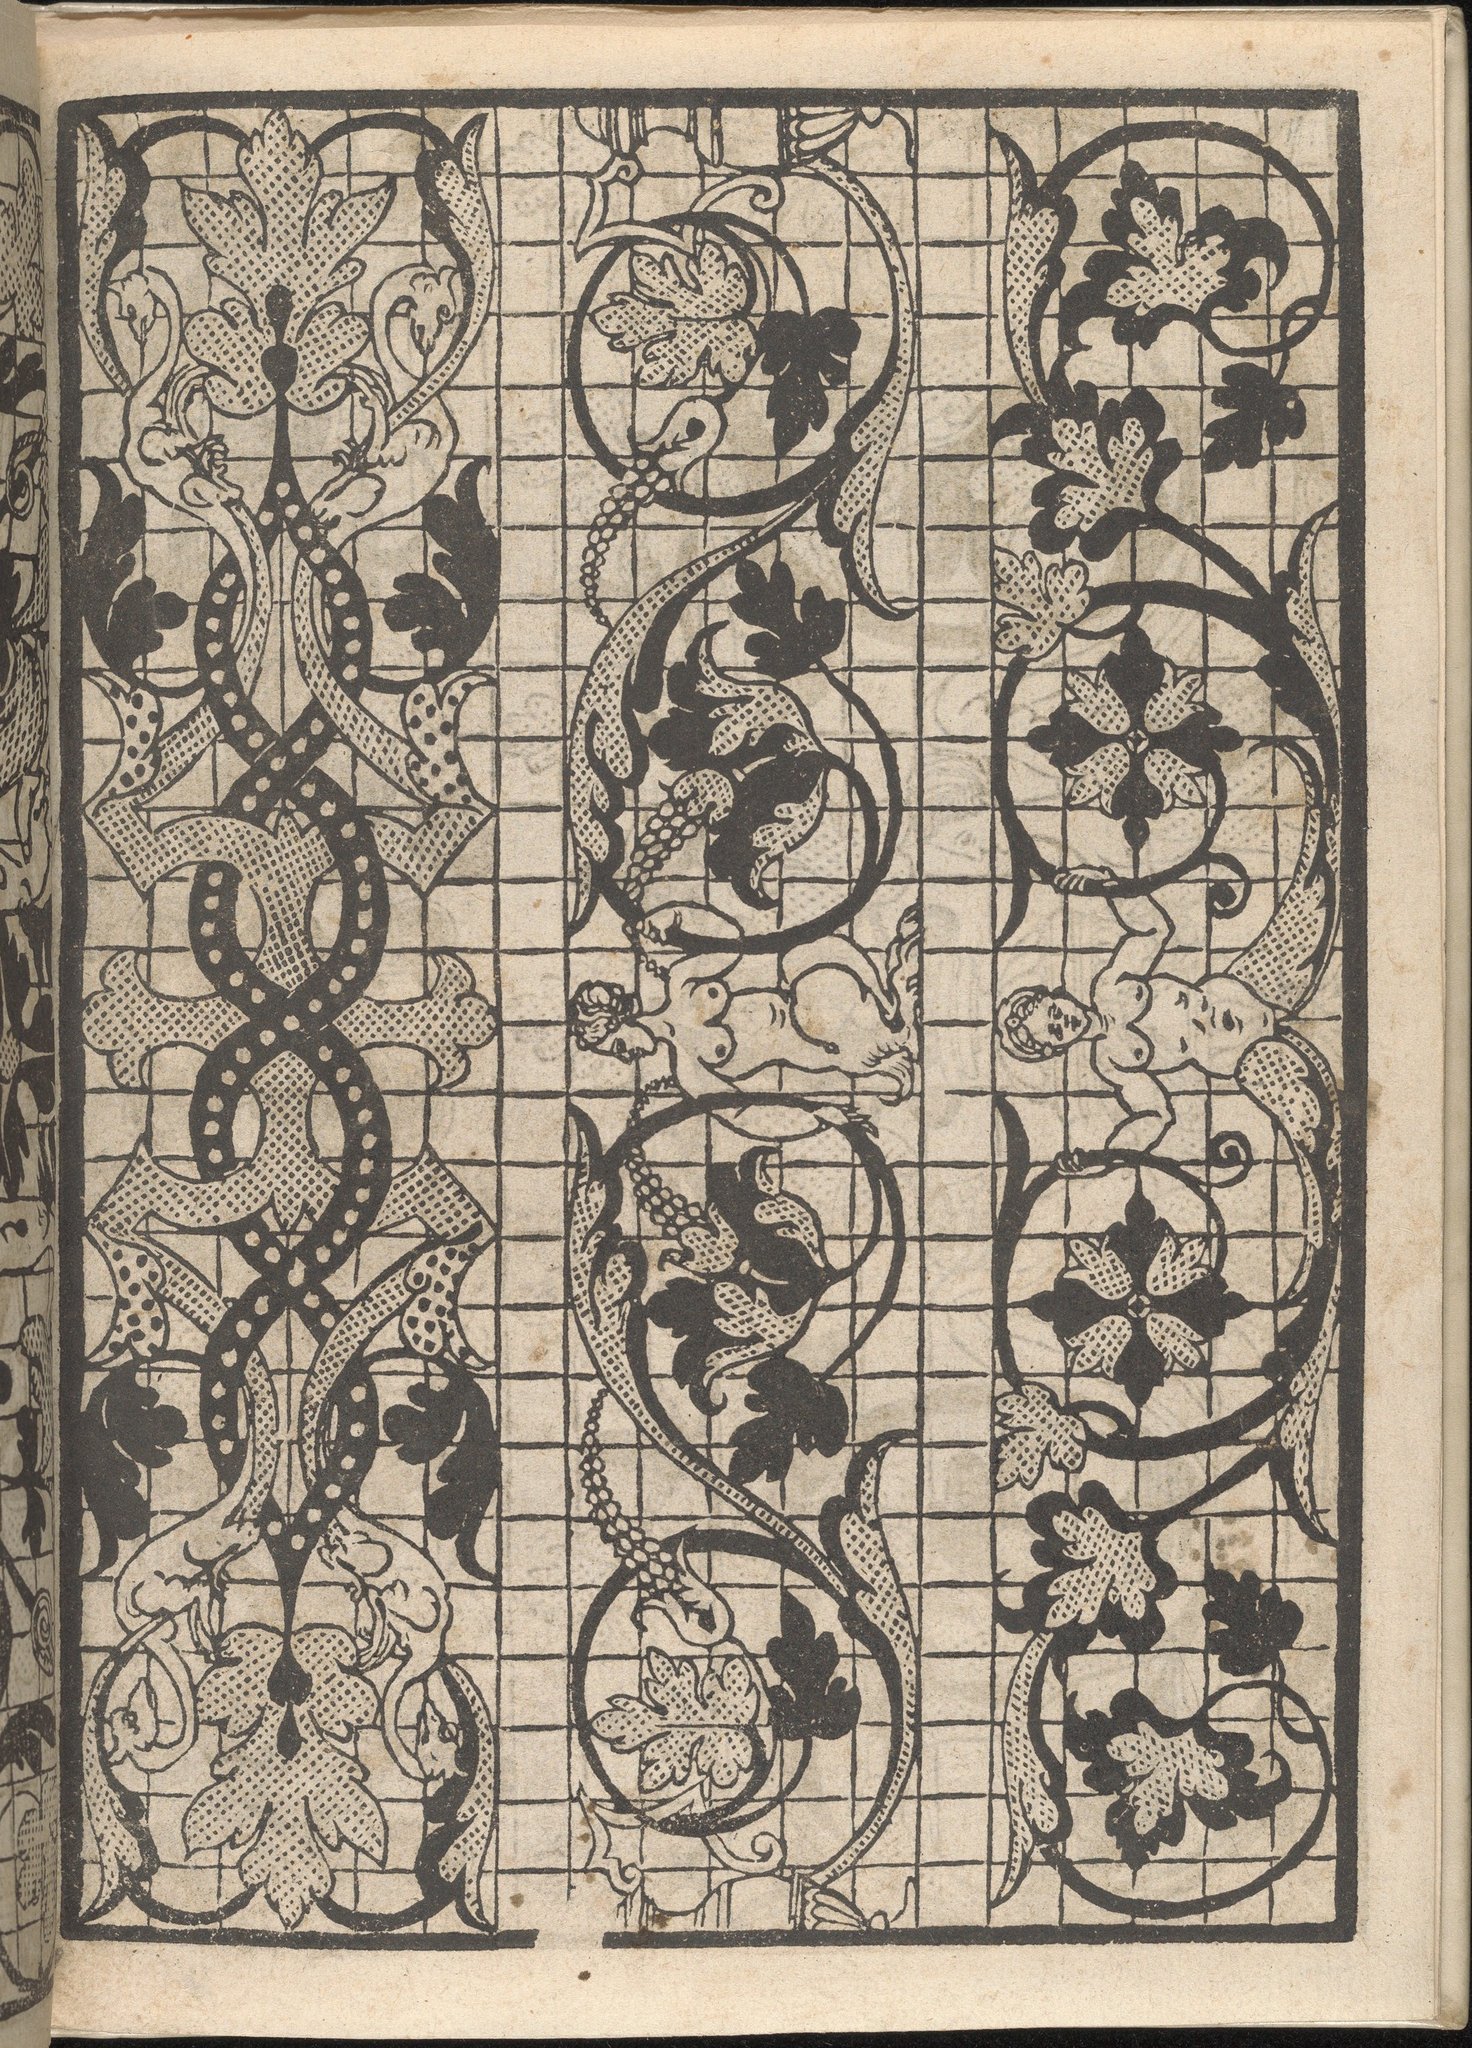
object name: book print ornament architecture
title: Splendore delle virtuose giovani, page 8 (verso)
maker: iseppo foresto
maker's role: designer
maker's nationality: italian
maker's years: 1520-1580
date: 1564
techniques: woodcut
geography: italy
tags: flowers